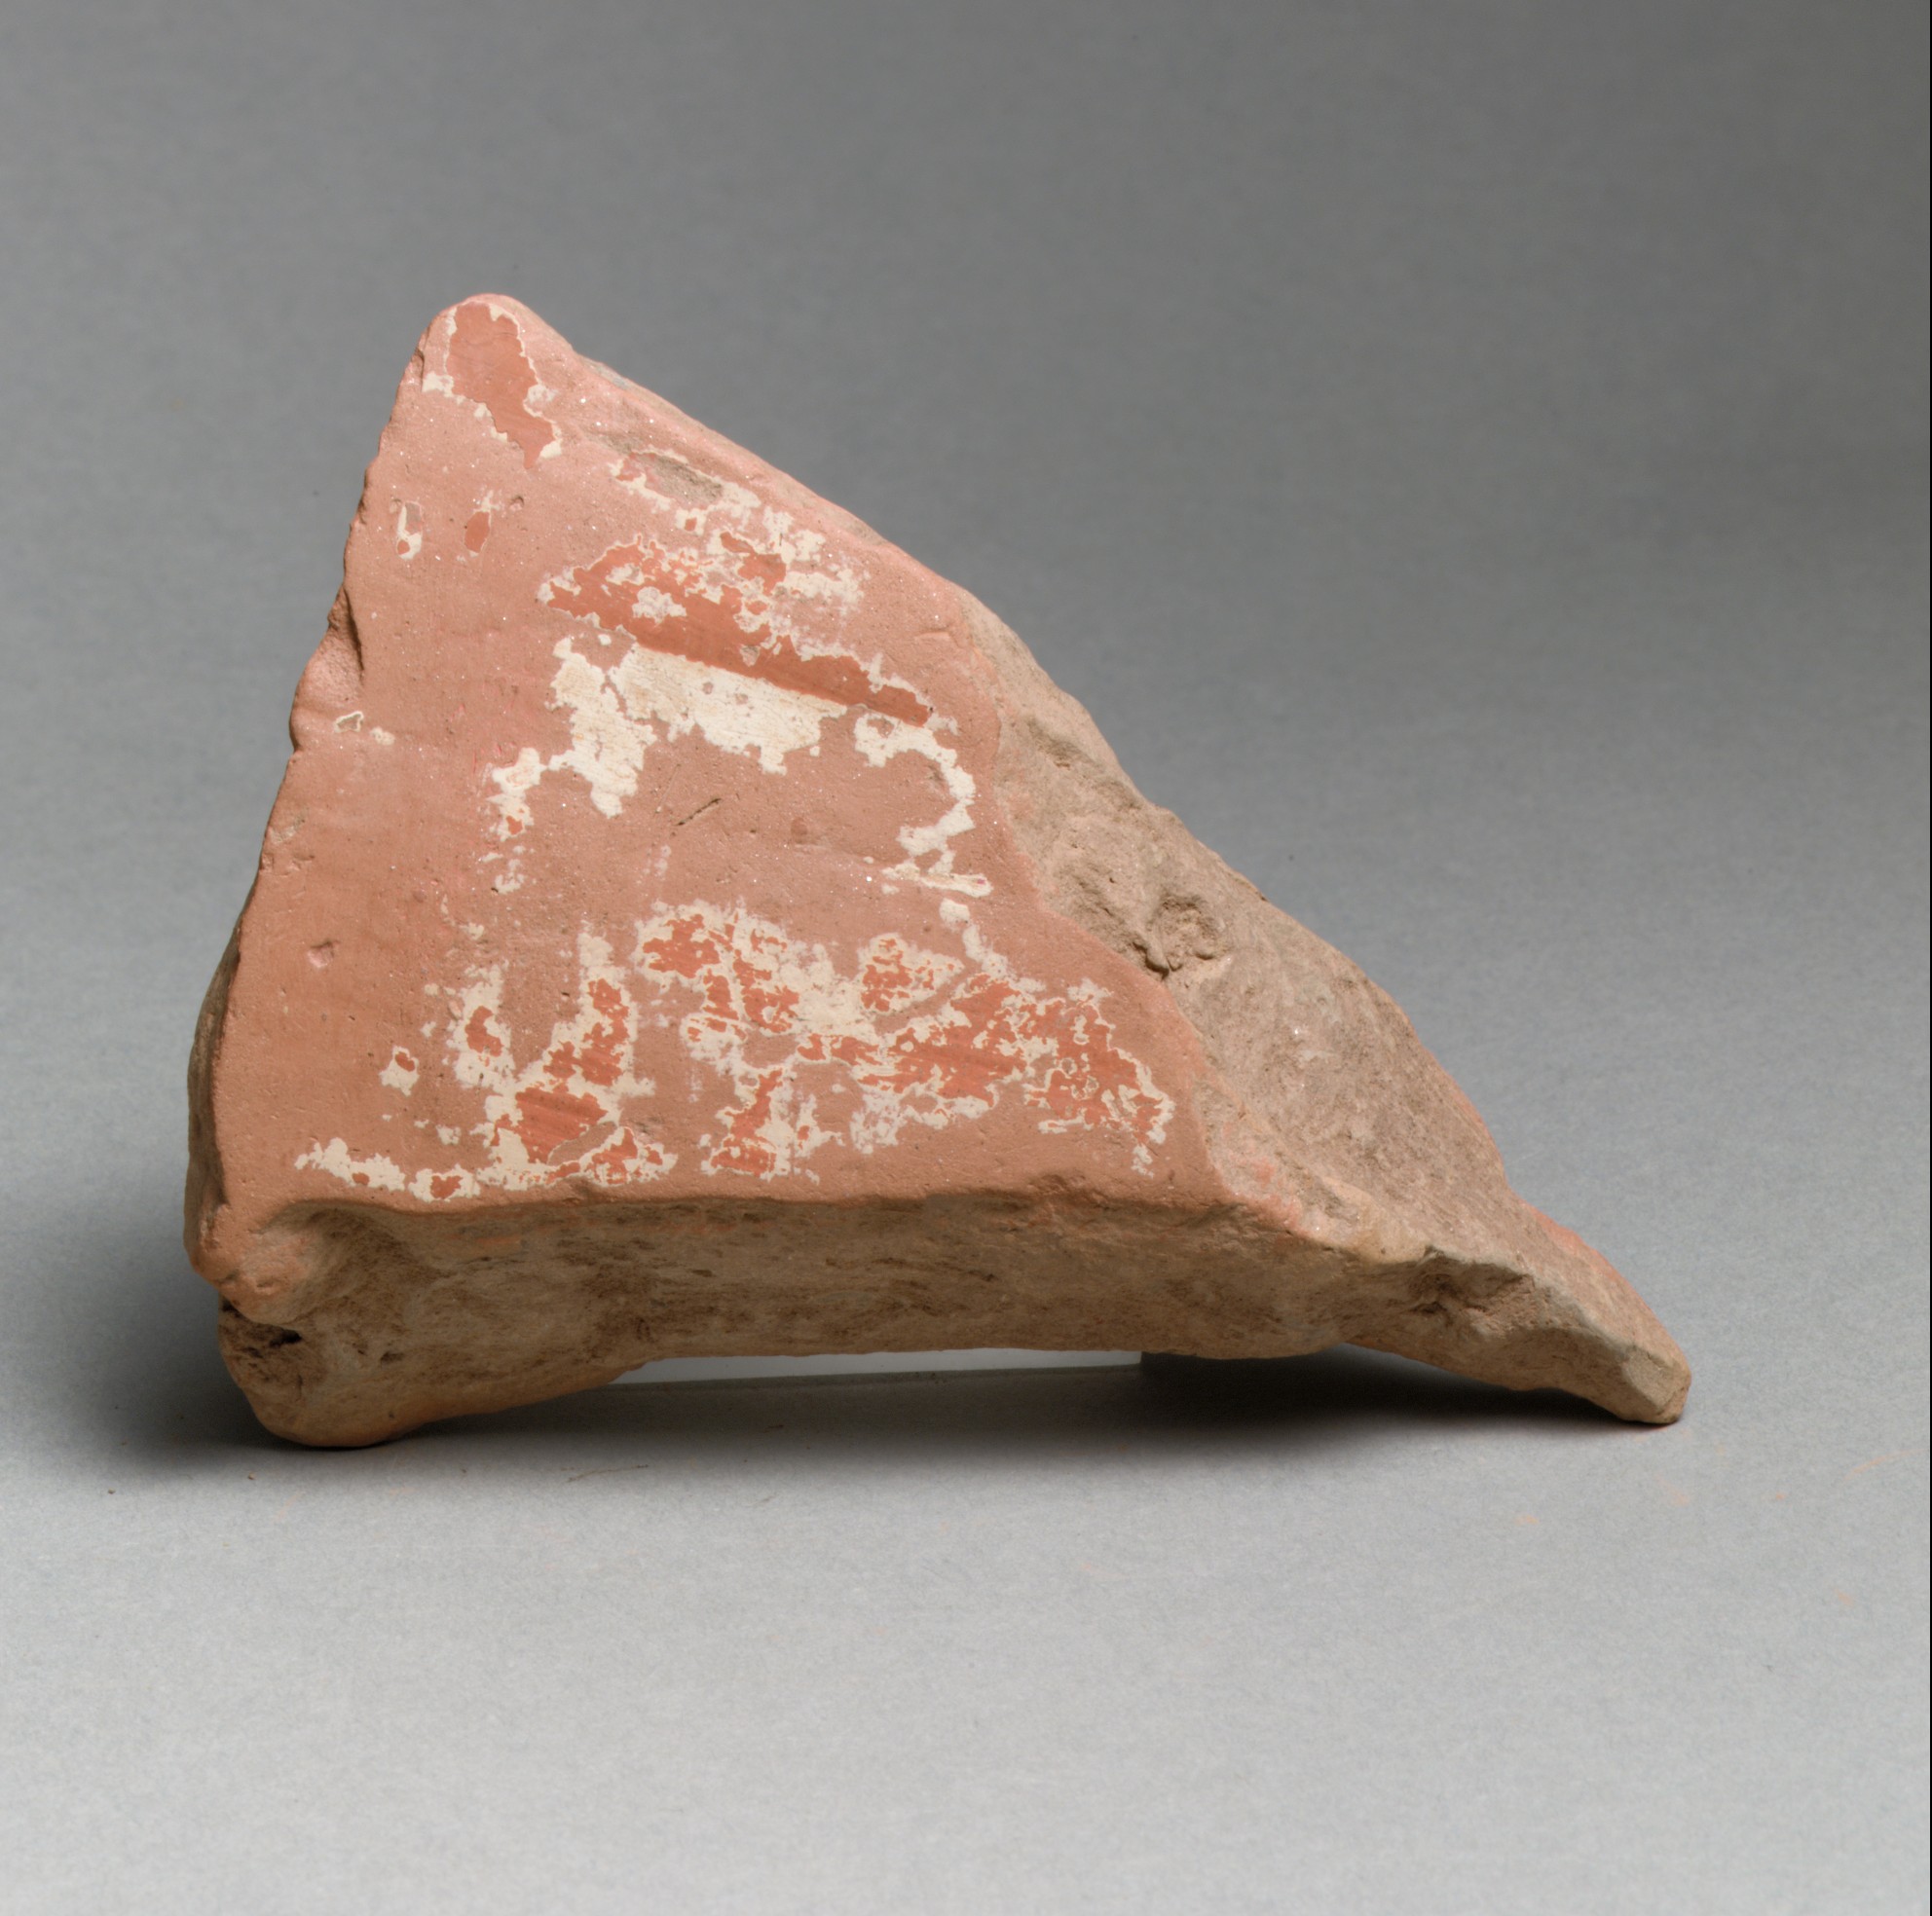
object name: vase fragment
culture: greek or lydian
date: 900-30 BCE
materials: terracotta